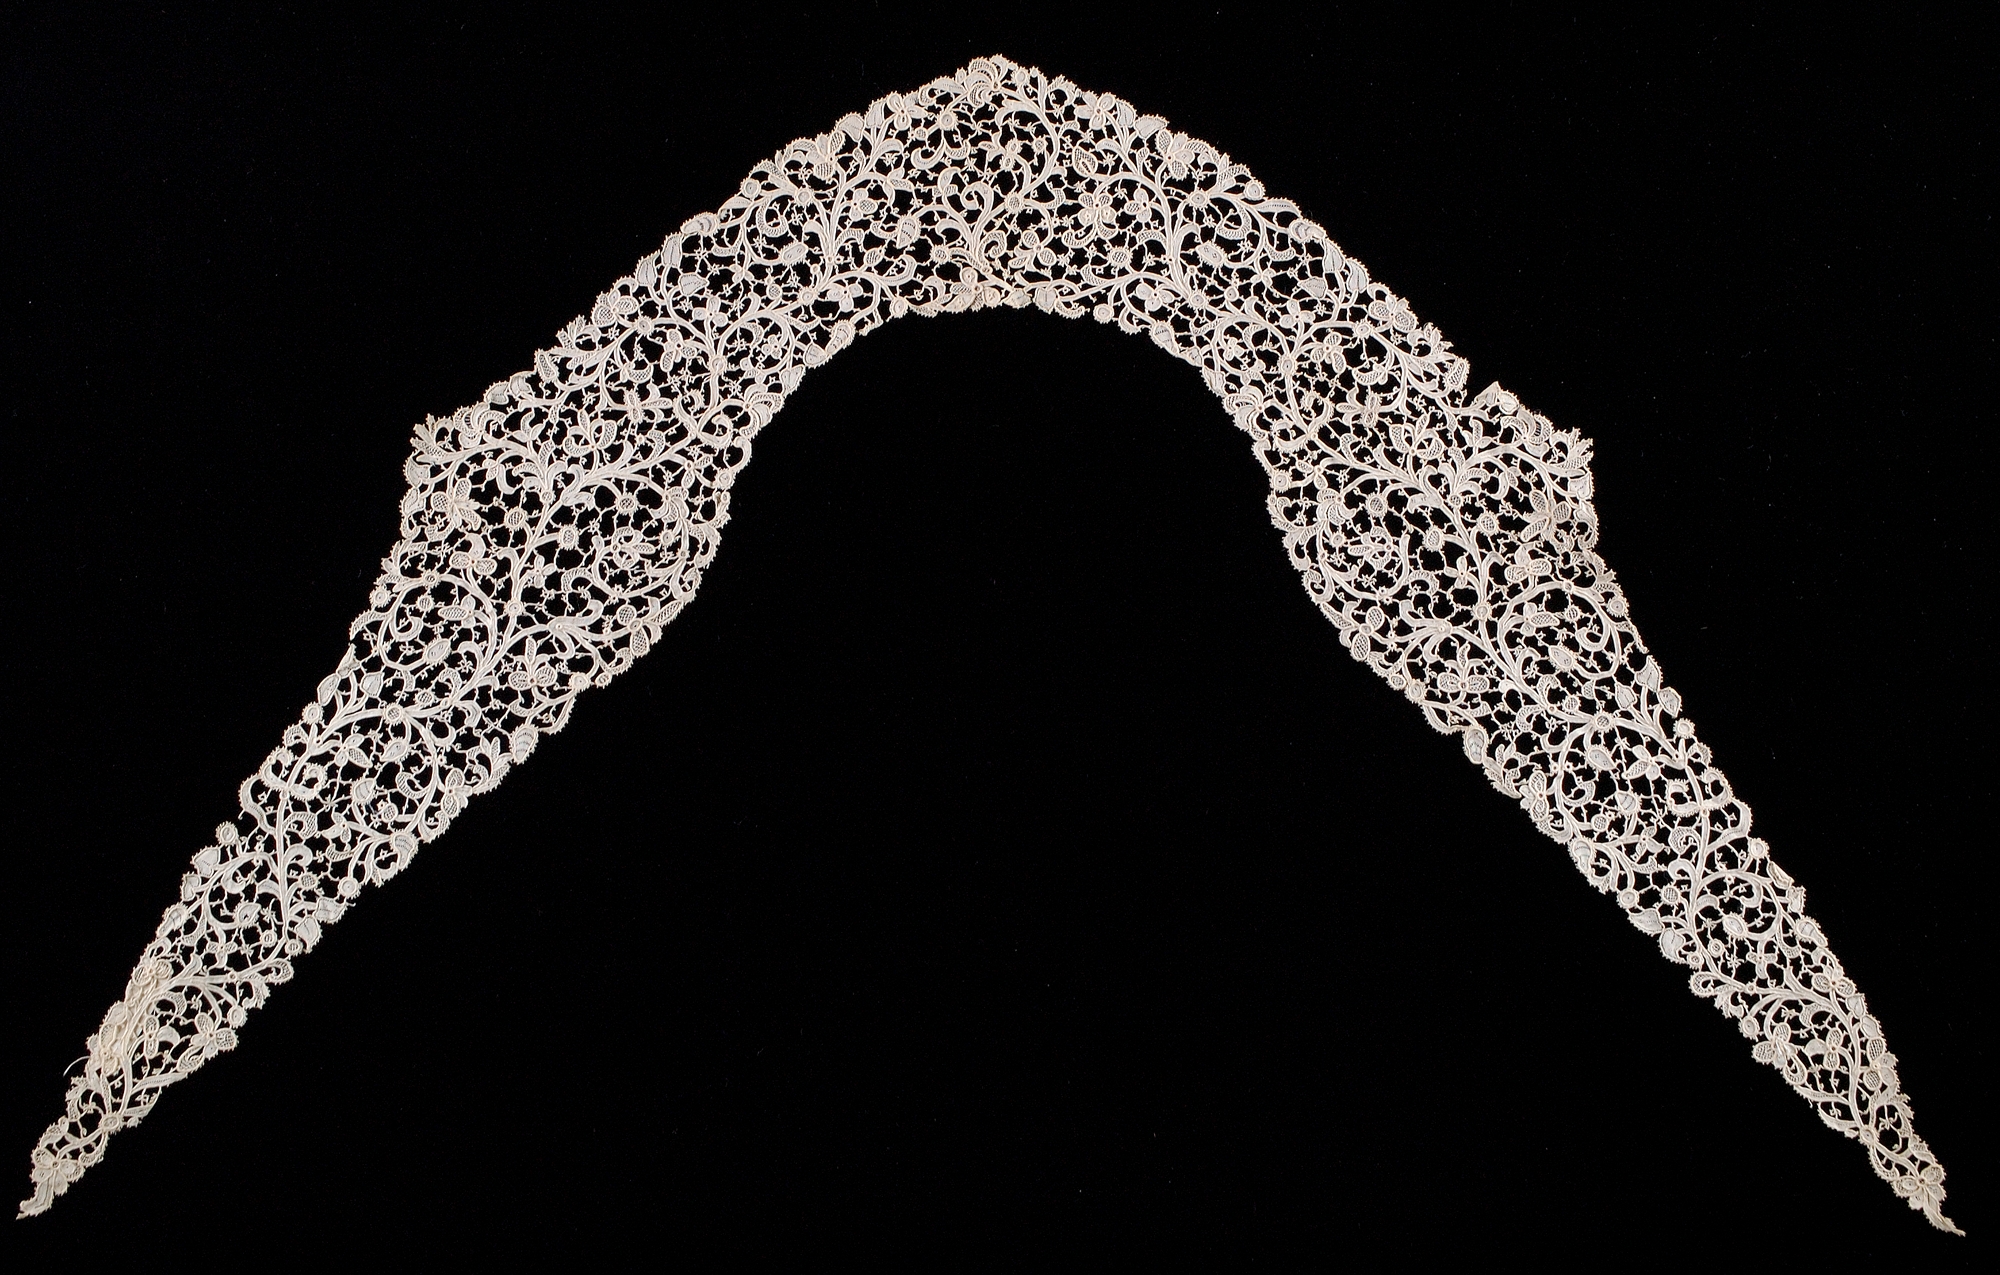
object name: collar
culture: italian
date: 1767-1800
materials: linen